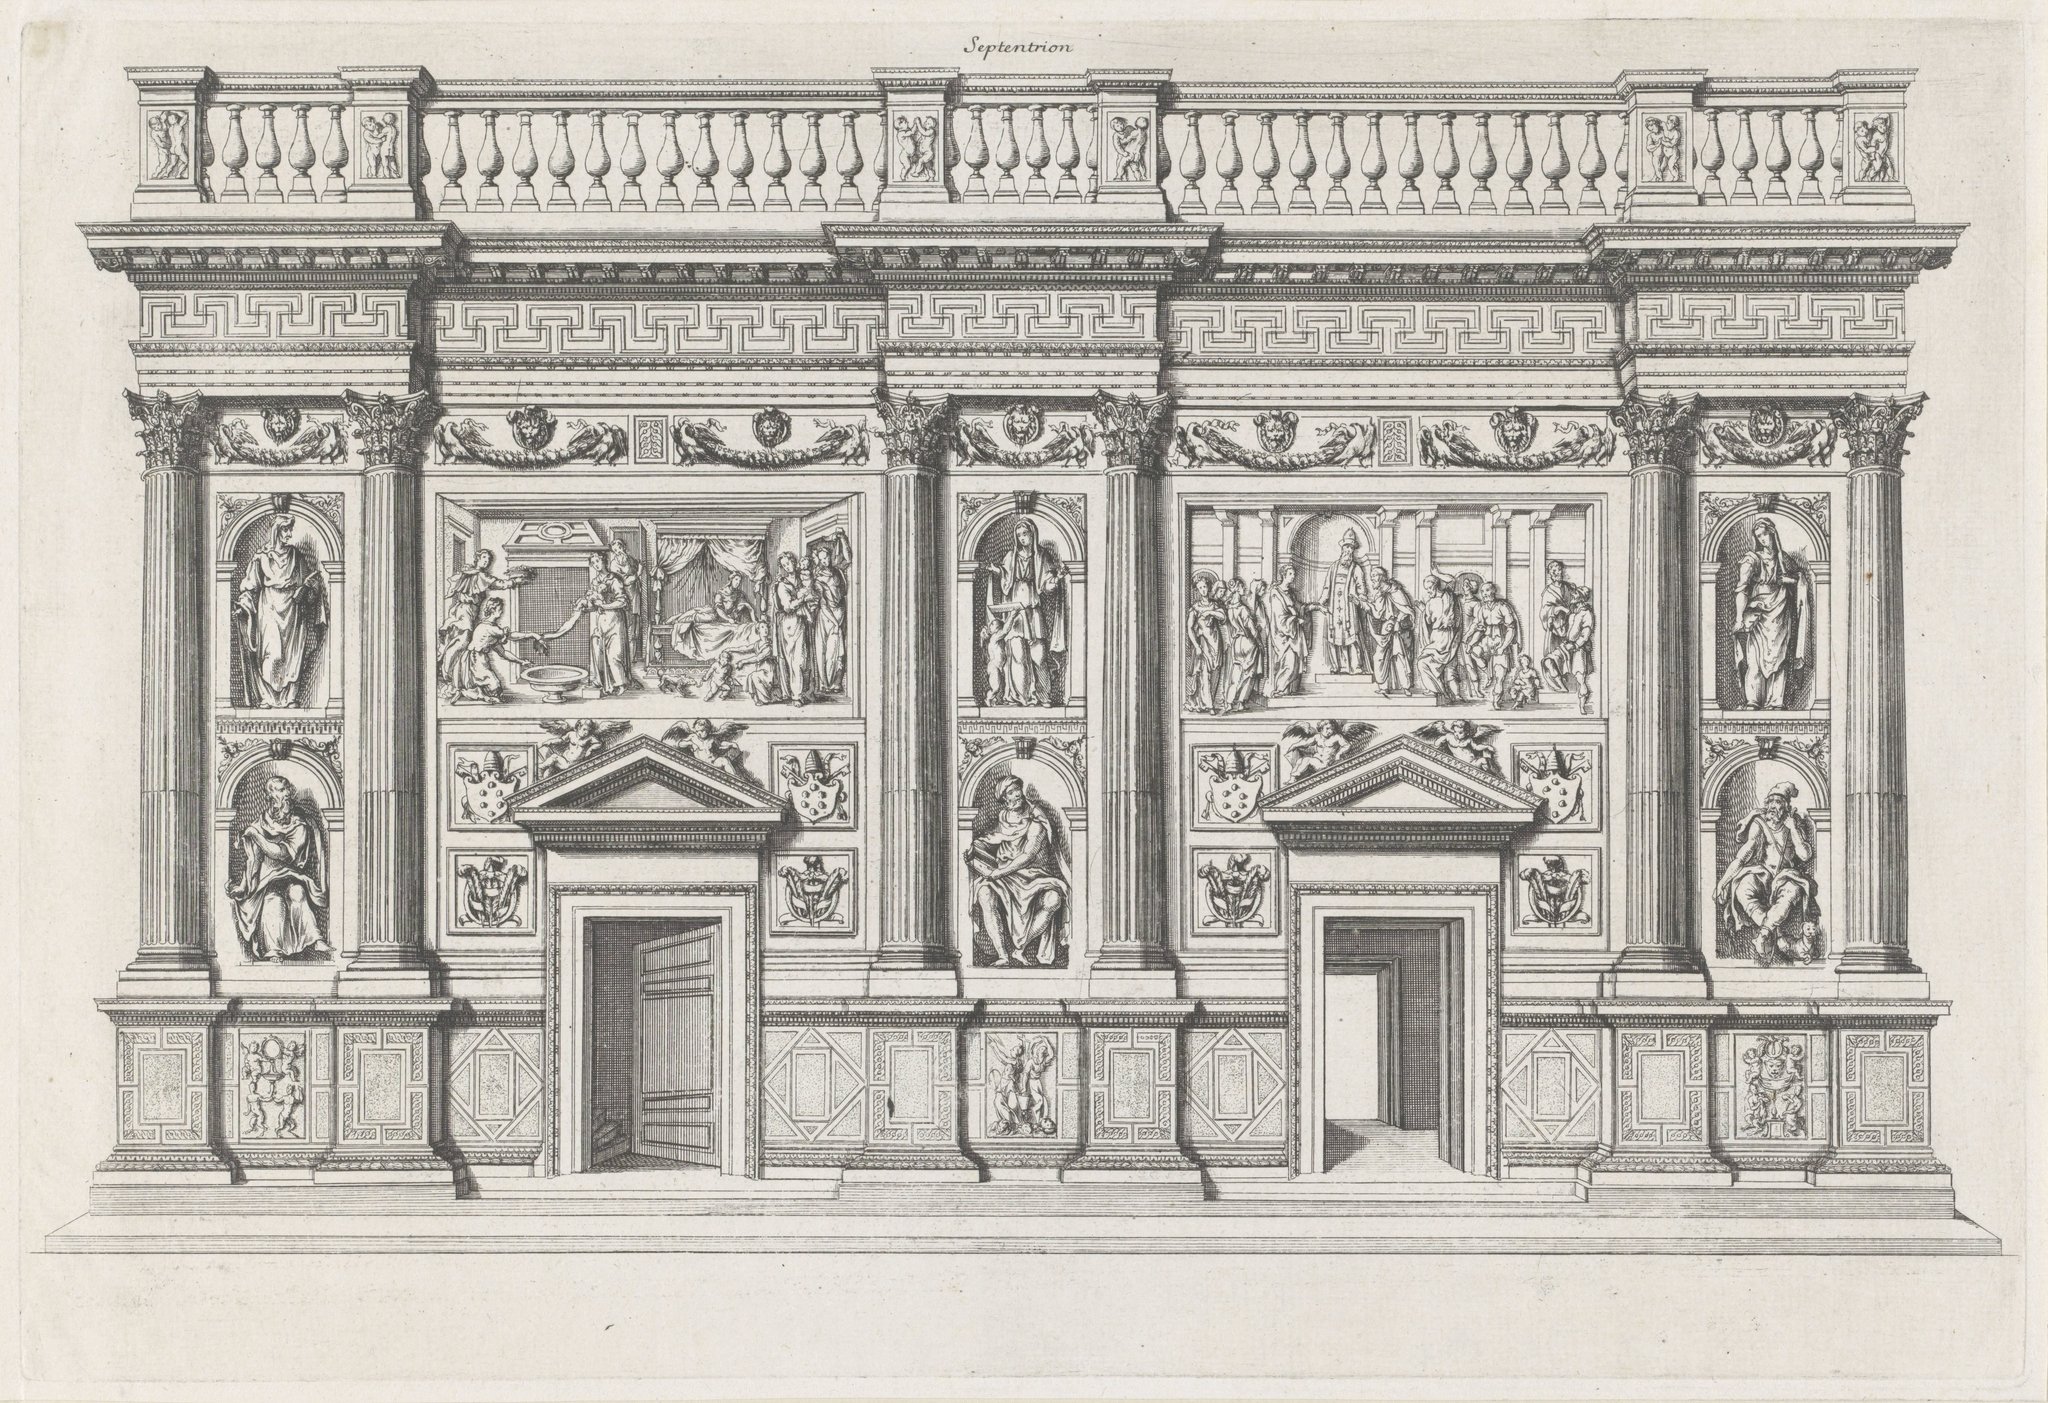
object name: print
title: Heilig Huis van de Maagd Maria, septentrion-zijde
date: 1649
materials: paper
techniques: etching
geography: paris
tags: parts of church interior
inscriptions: collector's mark: Lugt 240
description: De septentrion-zijde van de marmeren renaissance behuizing van het Heilig Huis van de Maagd Maria in de Basilica della Casa Santa in Loreto. De behuizing bevat beelden en reliëfs door Andrea Sansovino, Ranieri Nerucci en Antonio da Sangallo de Jongere. Het geheel is ontworpen door Donato Bramante.